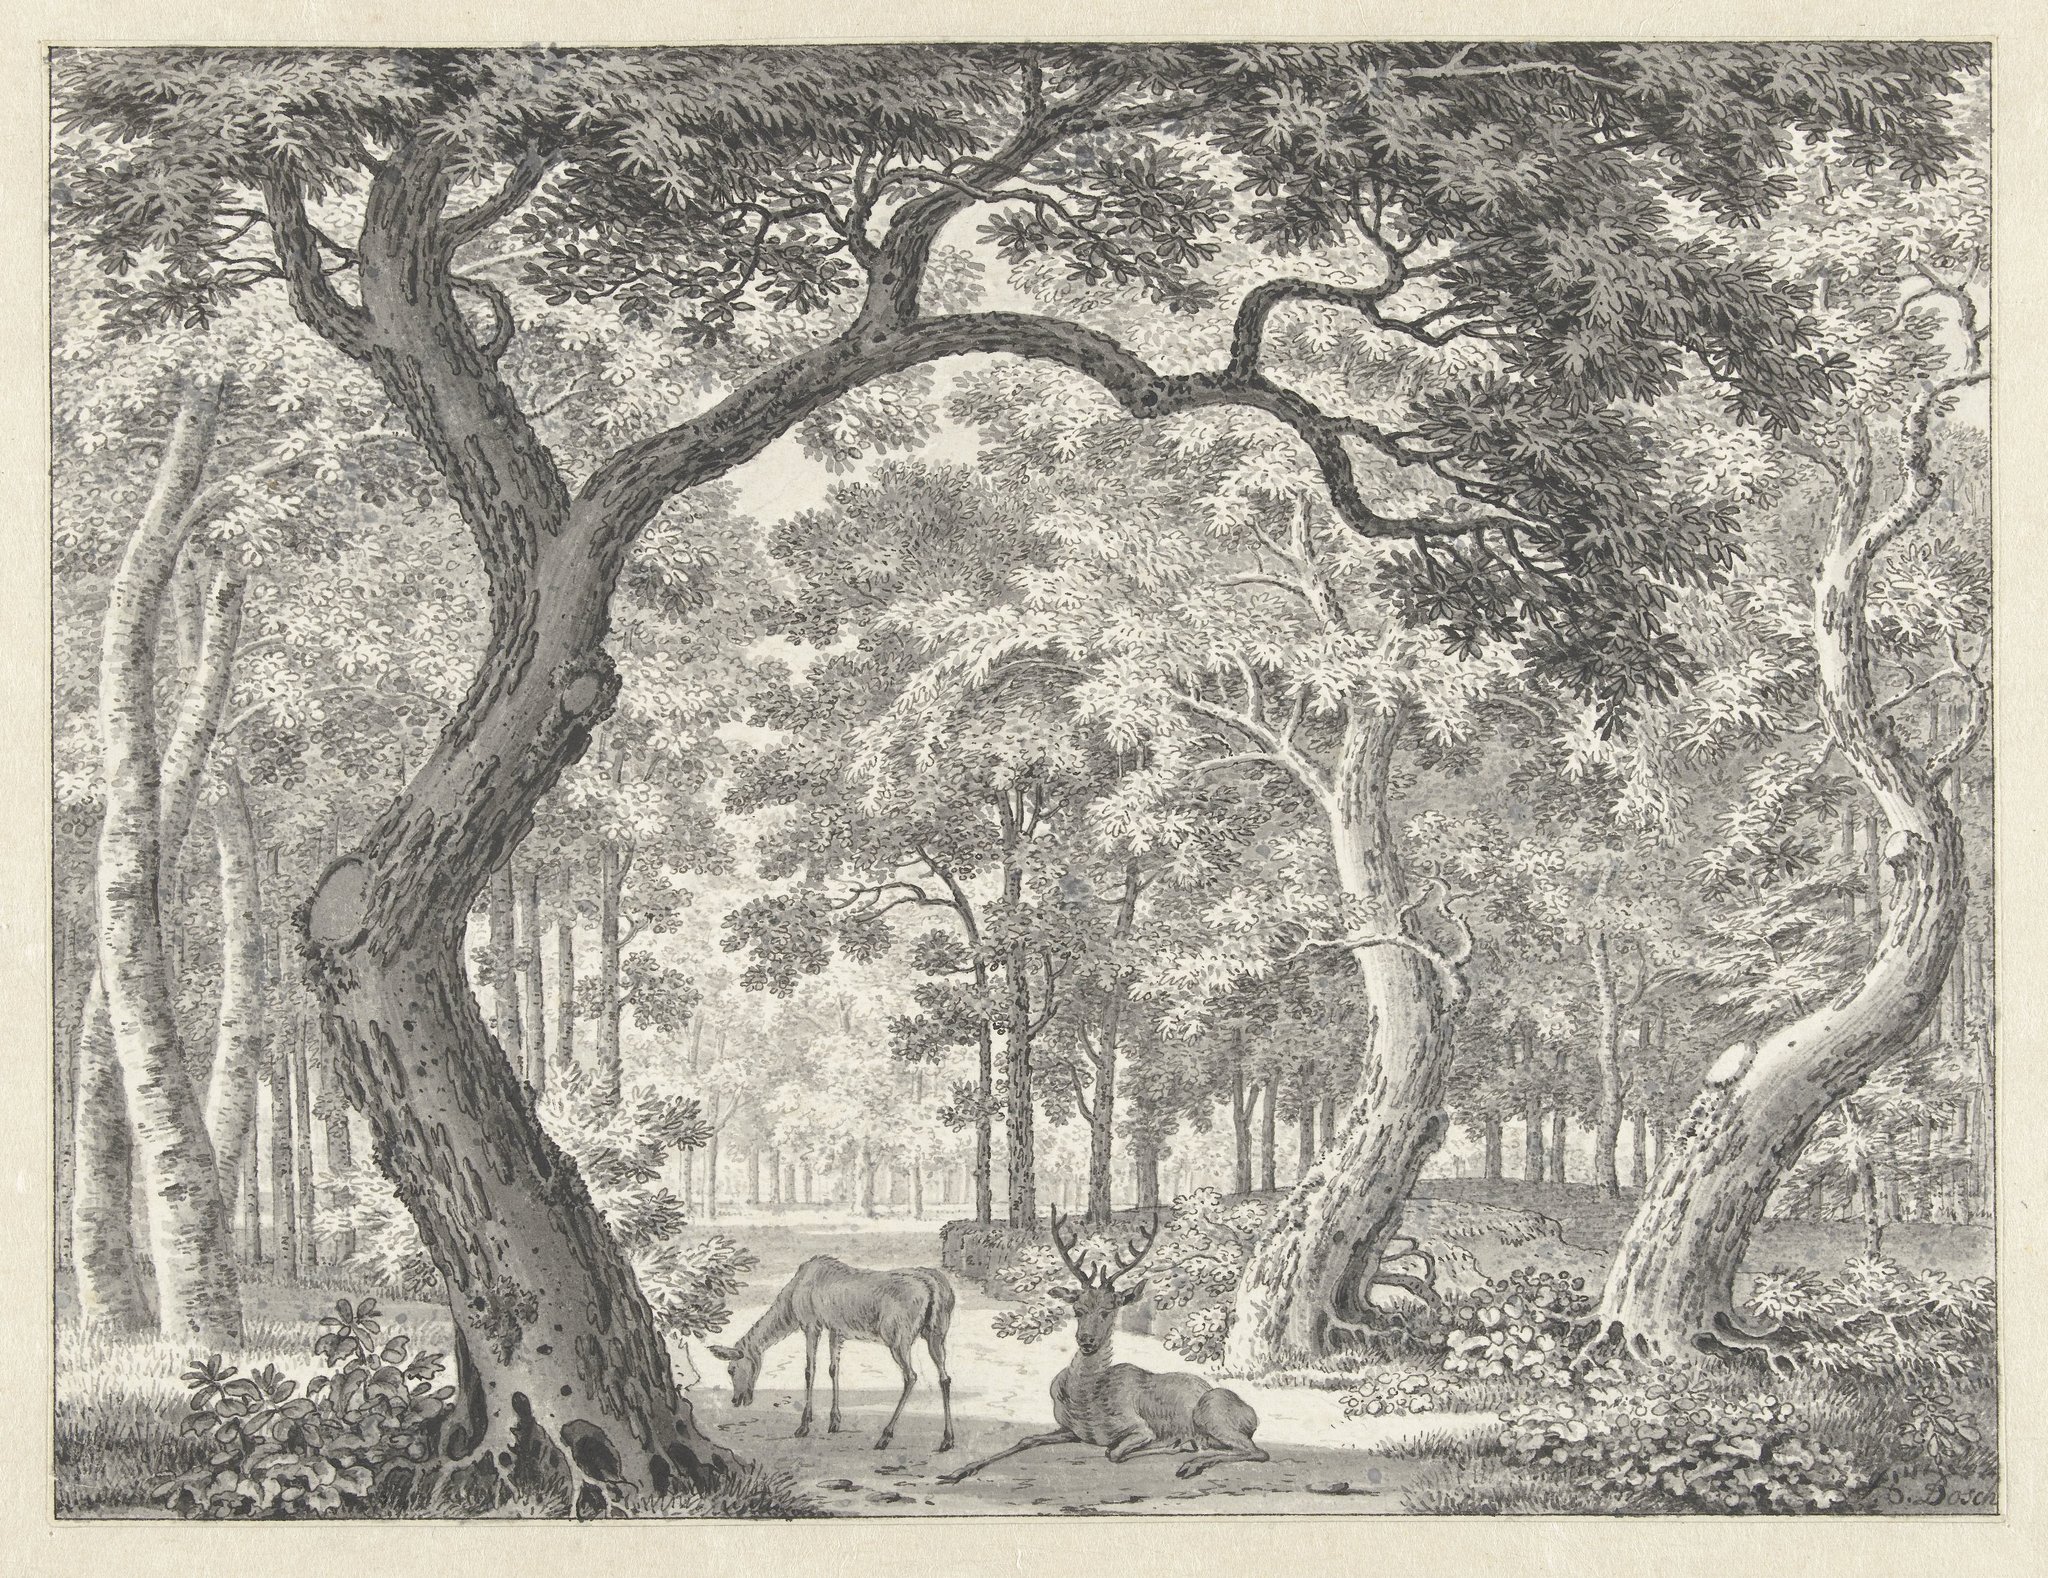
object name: drawing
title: Bosgezicht met twee herten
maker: johannes de bosch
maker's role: draughtsman, print maker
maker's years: 1713-1785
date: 1760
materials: ink, paper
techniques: brush, pen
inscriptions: date: ‘1760’